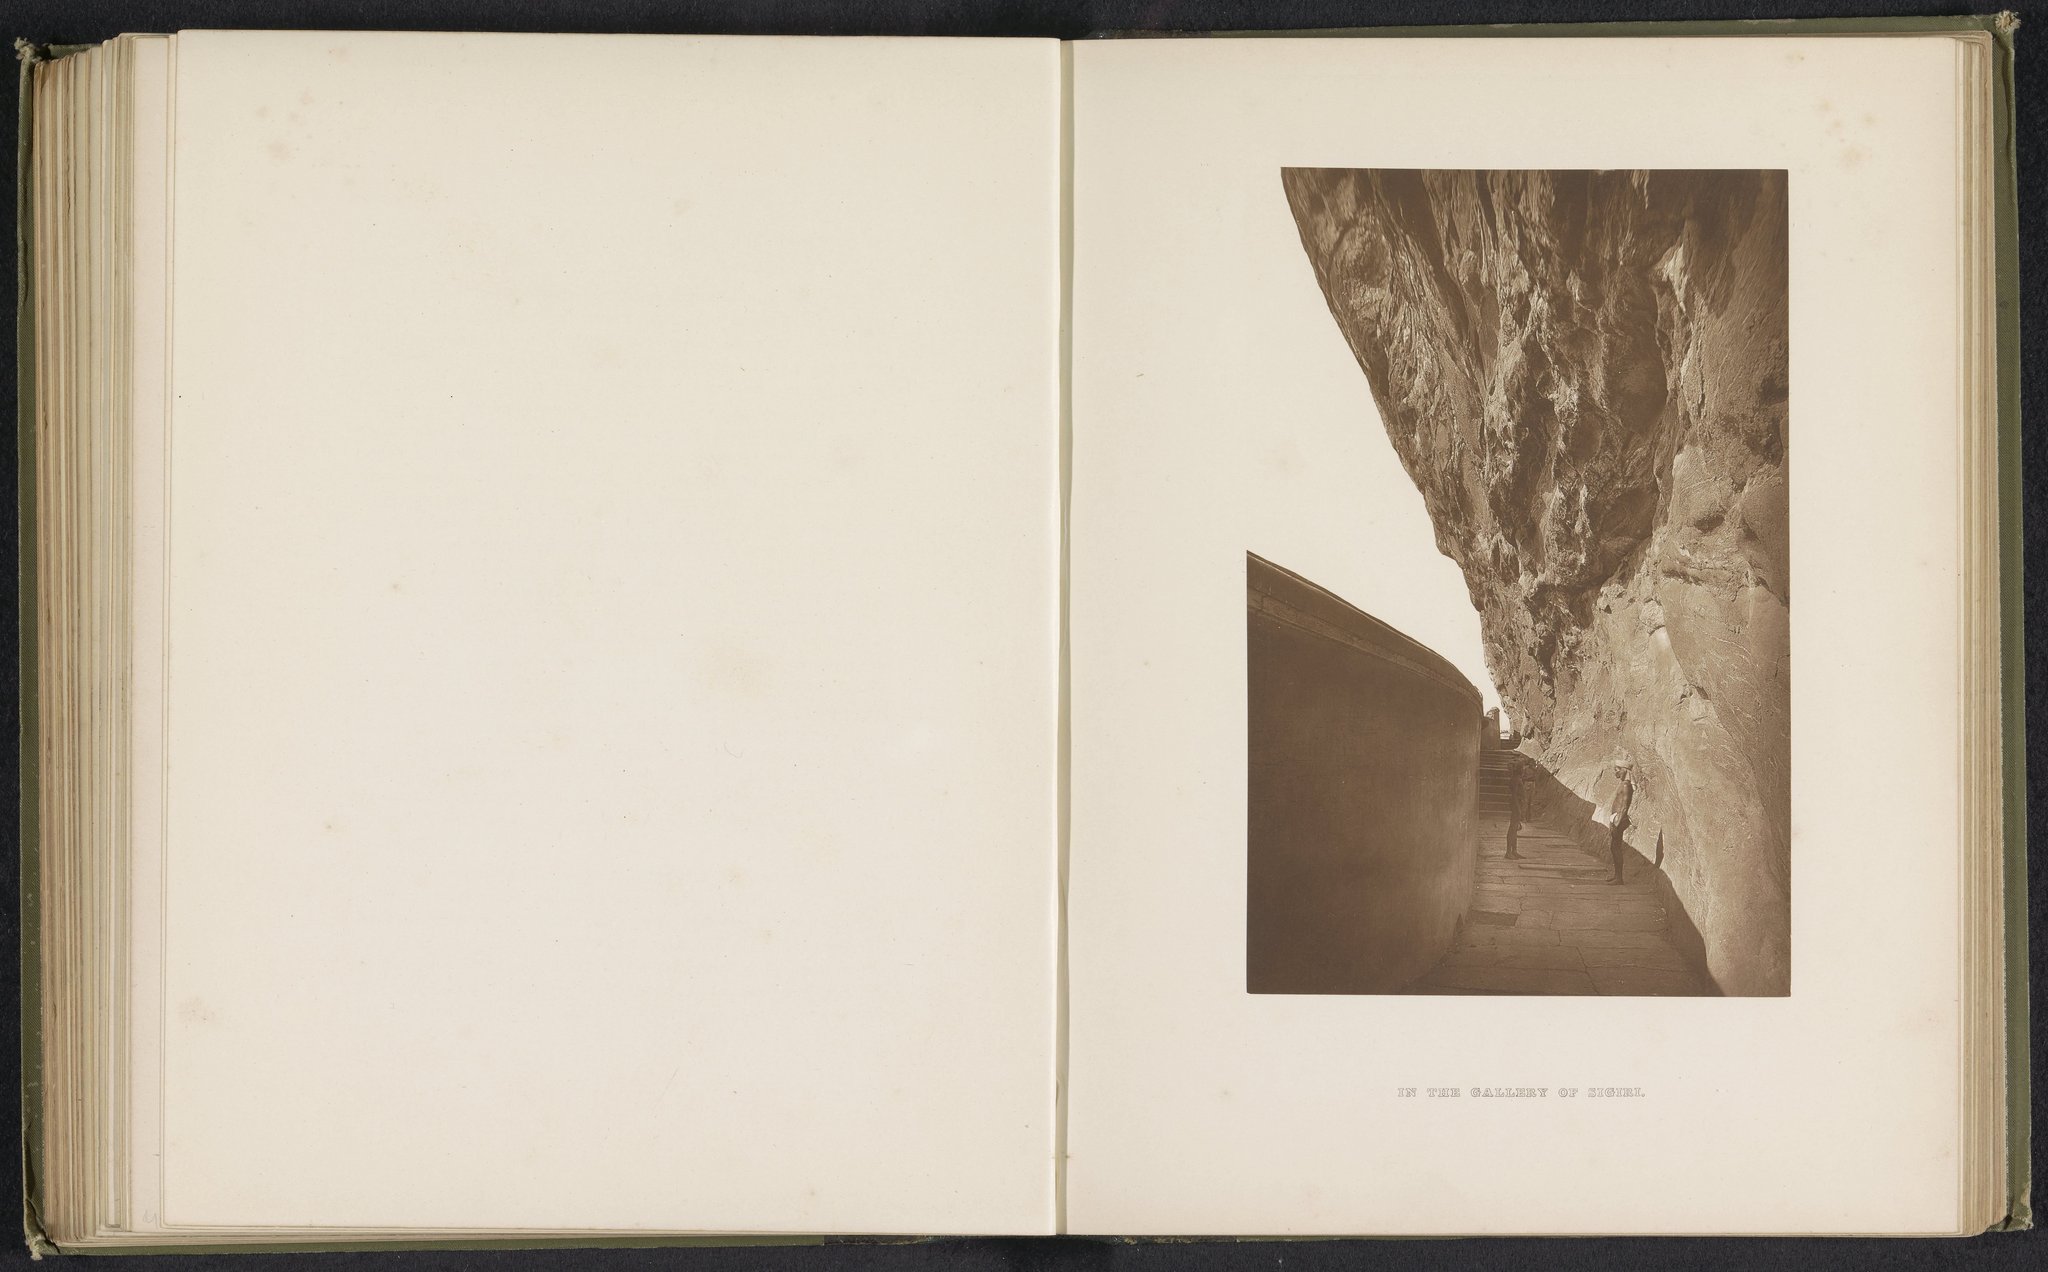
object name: photomechanical print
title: In the gallery of the Lion Rock at Sigiriya, Sri Lanka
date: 1896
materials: paper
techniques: woodburygravure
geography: sigiriya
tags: gallery (spacious corridor), rock-formations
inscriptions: title: ‘IN THE GALLERY OF SIGIRI.’